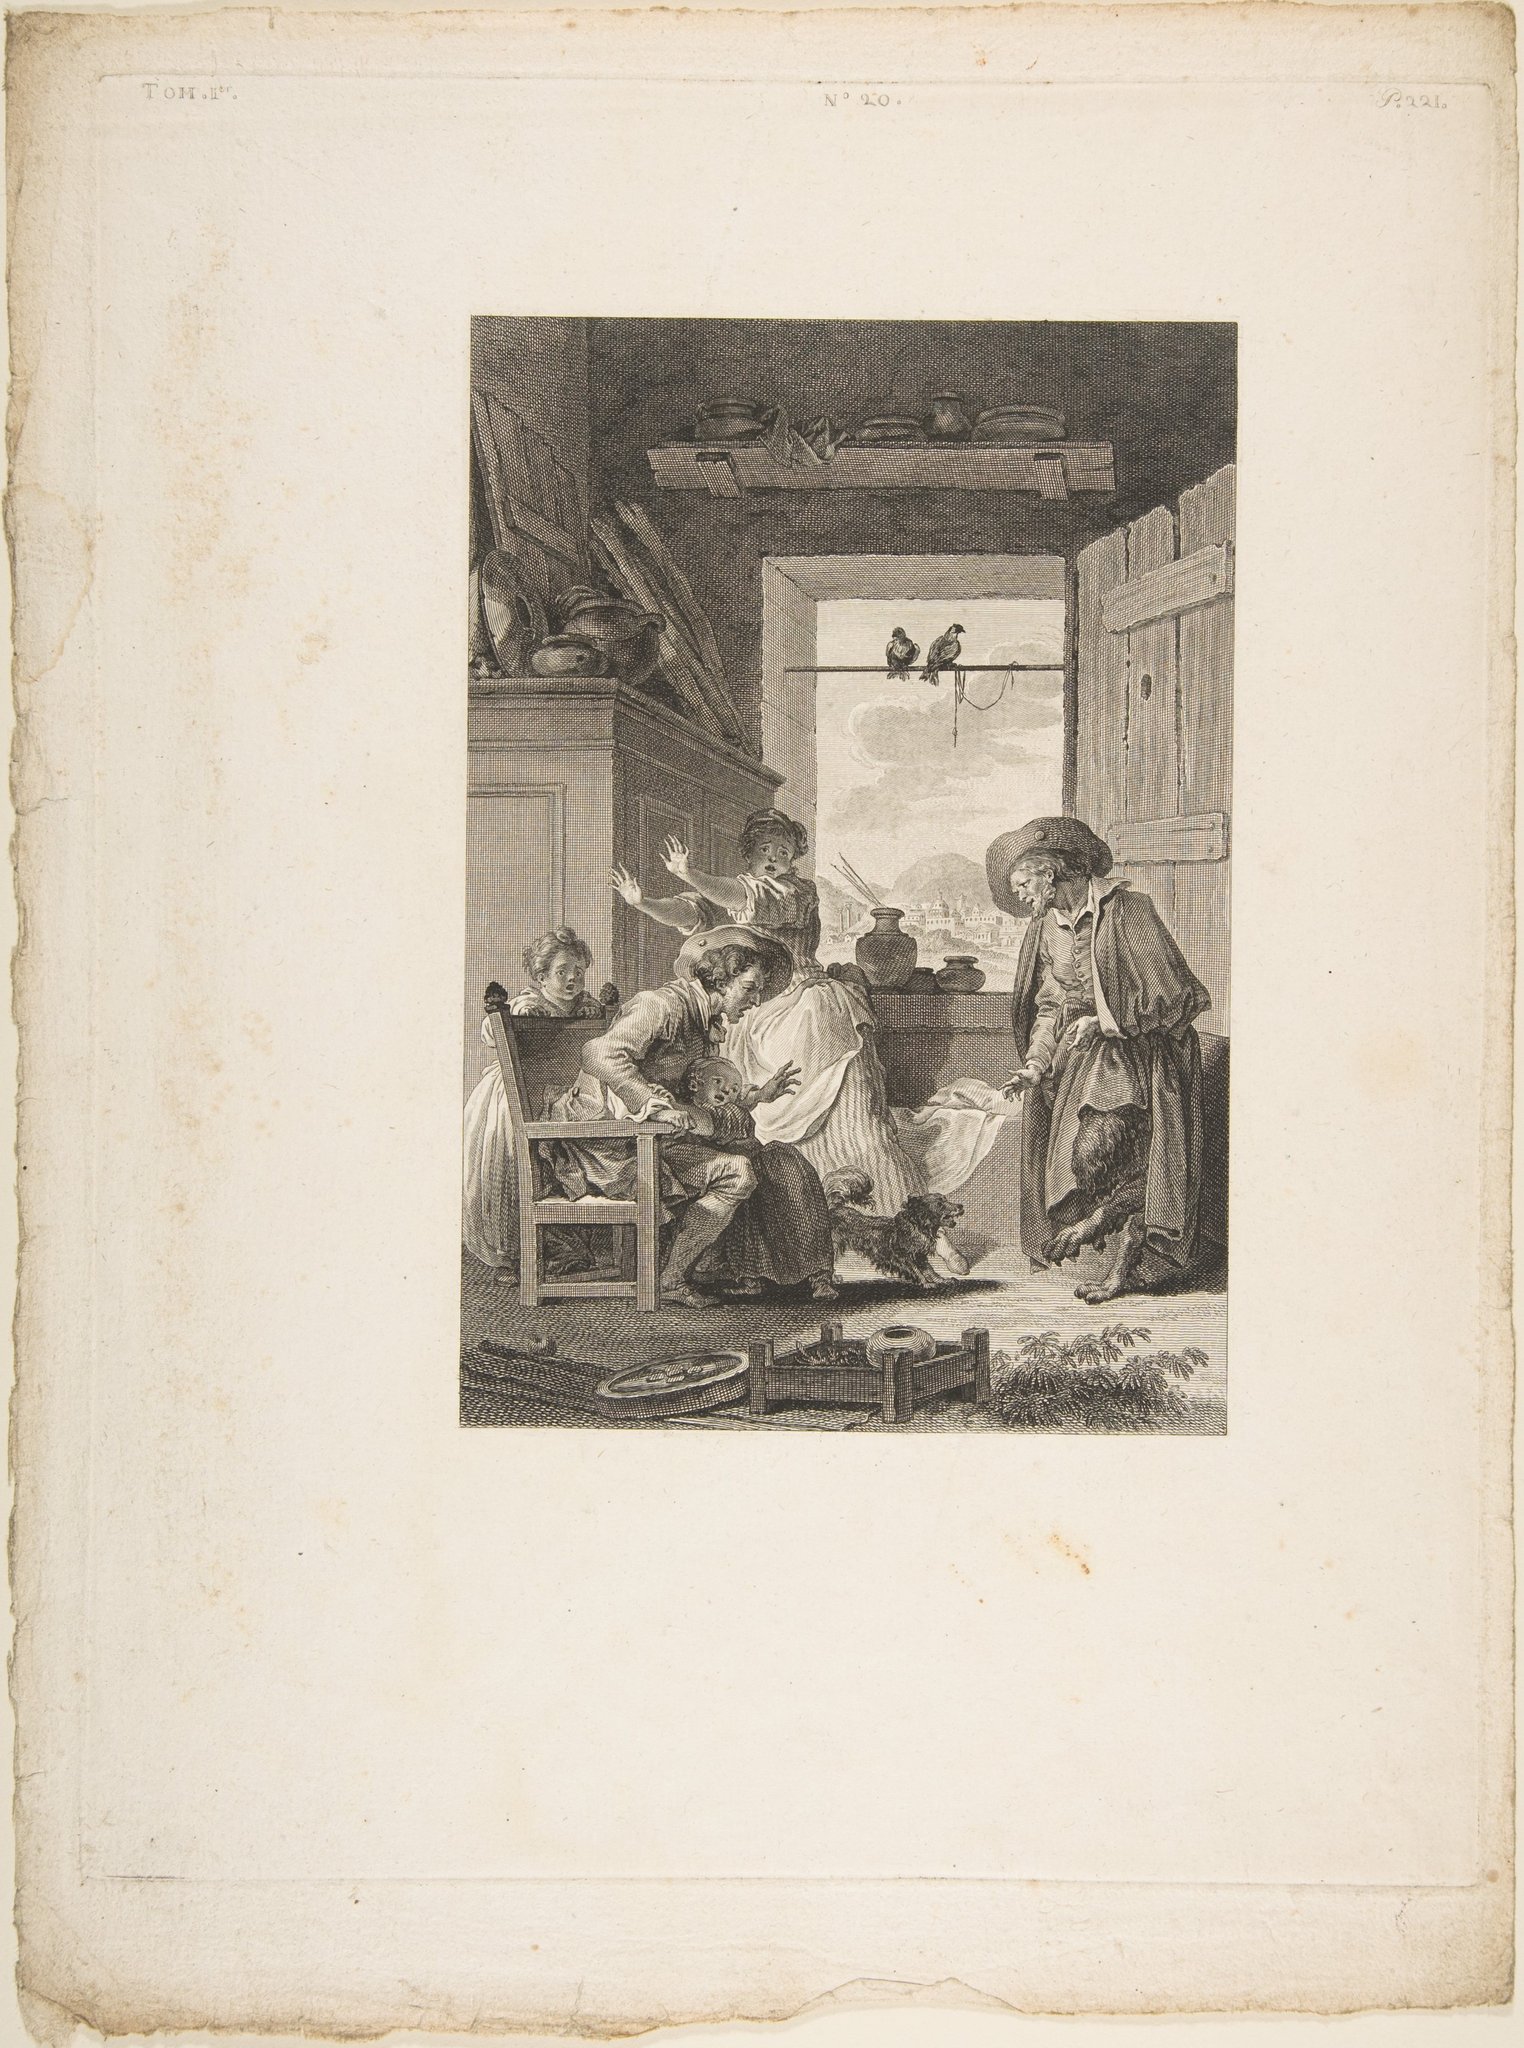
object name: print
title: Belphegor, from "Contes et nouvelles en vers par Jean de La Fontaine. A Paris, de l'imprimerie de P. Didot, l'an III de la République, 1795"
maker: jean-baptiste patas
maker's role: artist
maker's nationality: french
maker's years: 1744-1802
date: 1795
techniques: engraving, etching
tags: birds,interiors,fear,children,men,women,dogs